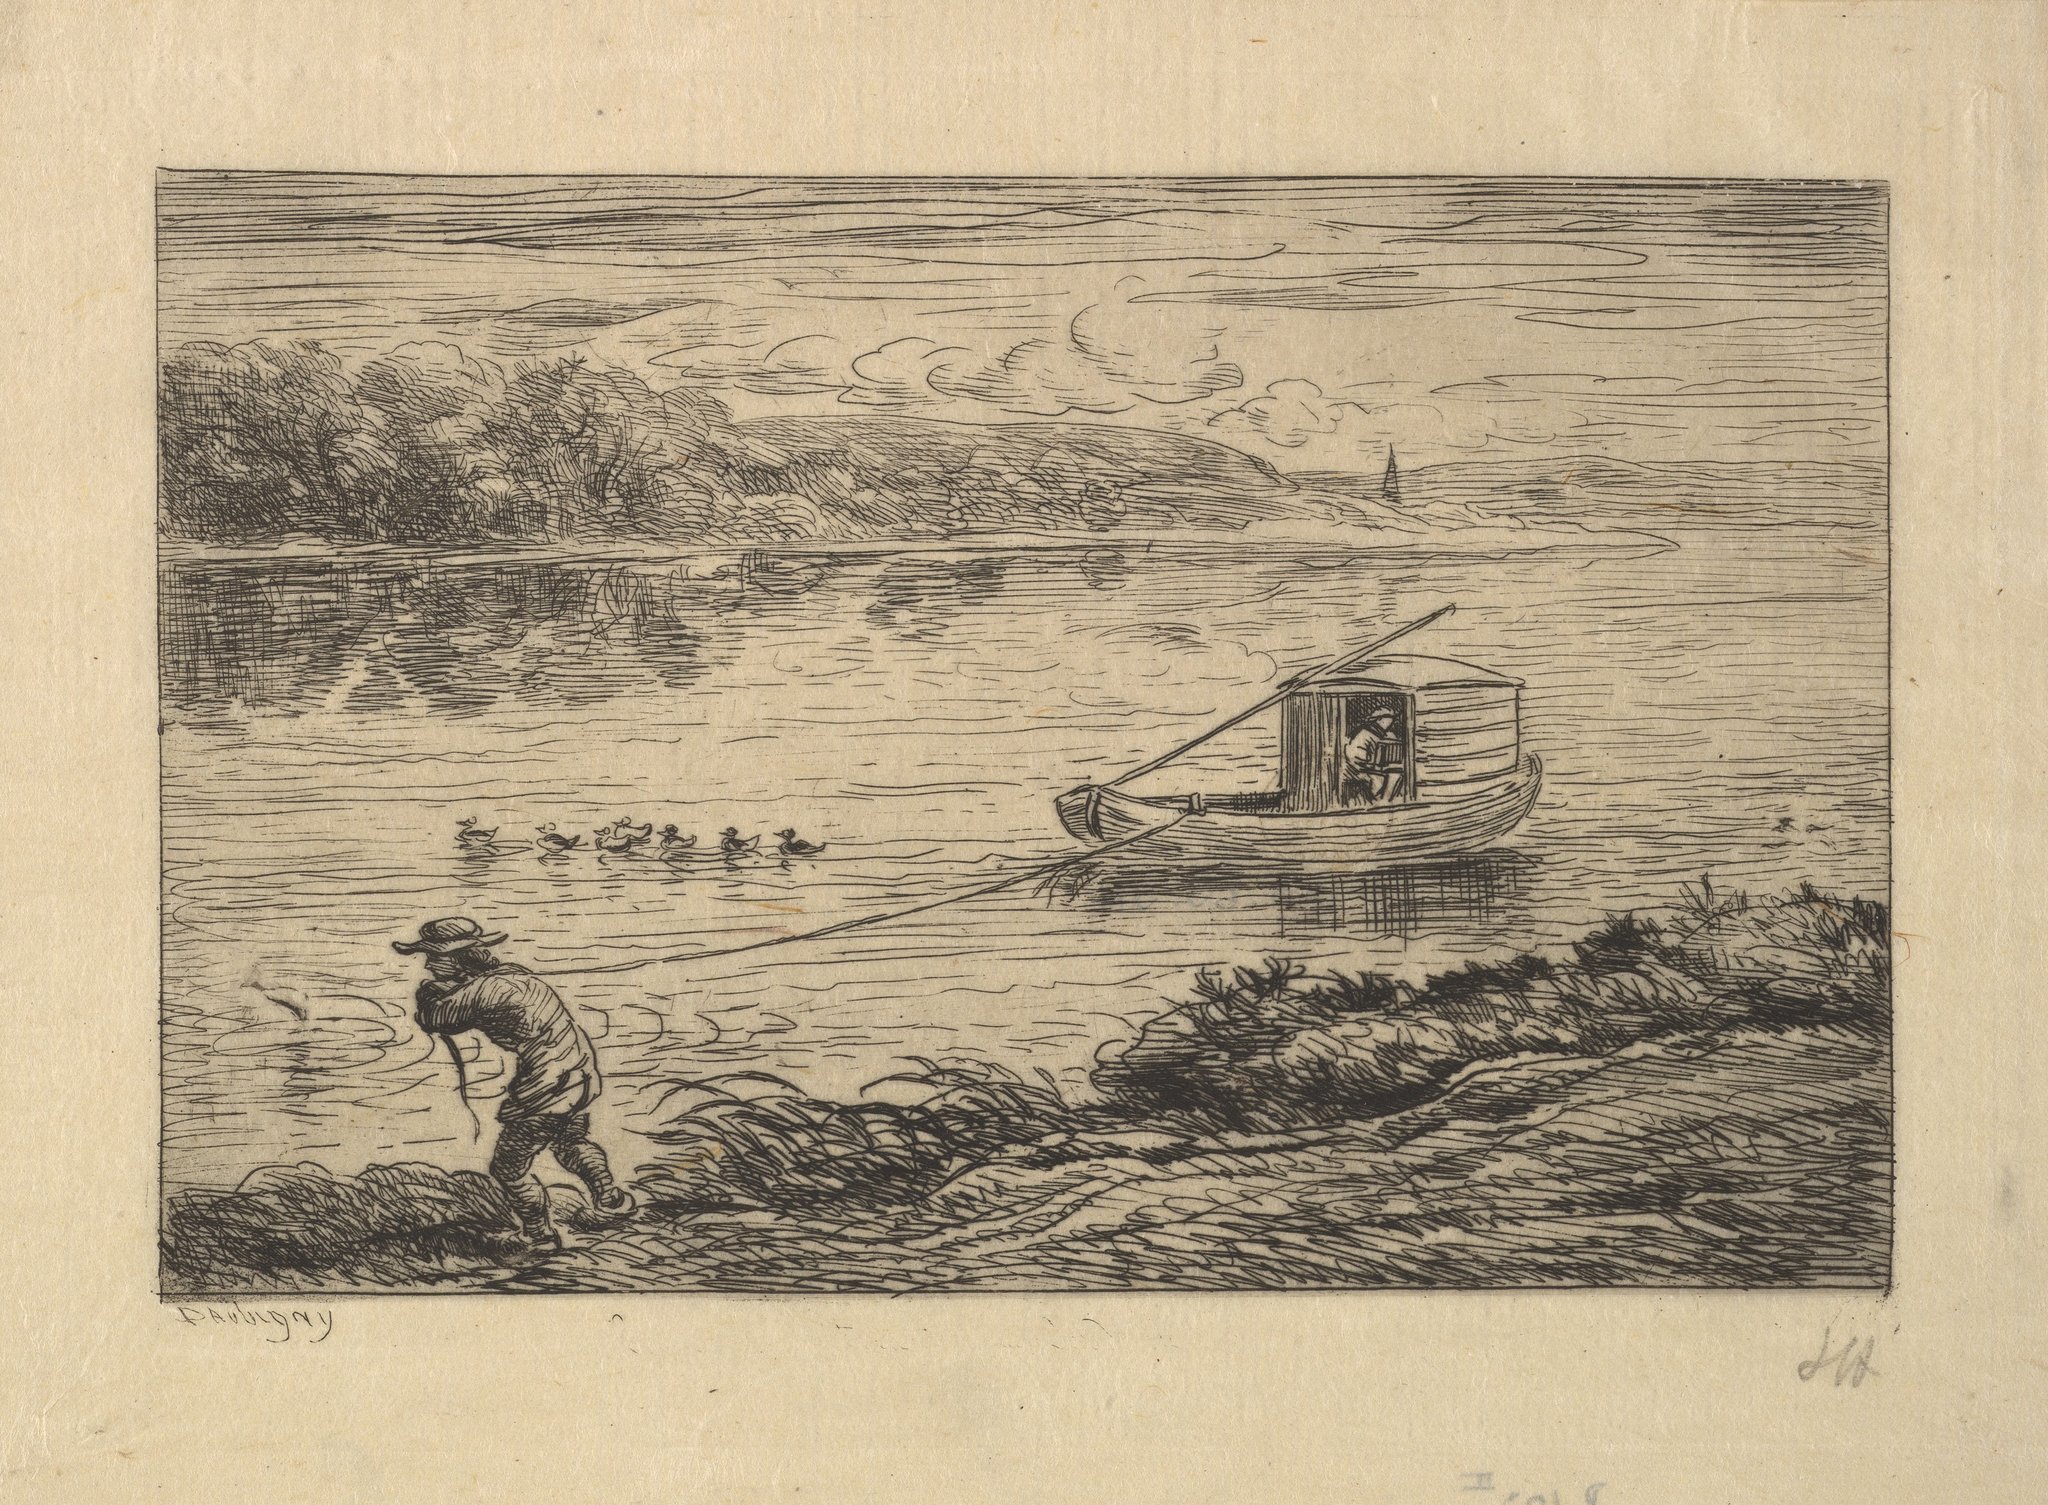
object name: print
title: The Cabin Boy Tows the Boat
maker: charles-françois daubigny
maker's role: artist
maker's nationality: french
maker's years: 1817-1878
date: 1861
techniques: etching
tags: boys,rivers,boats